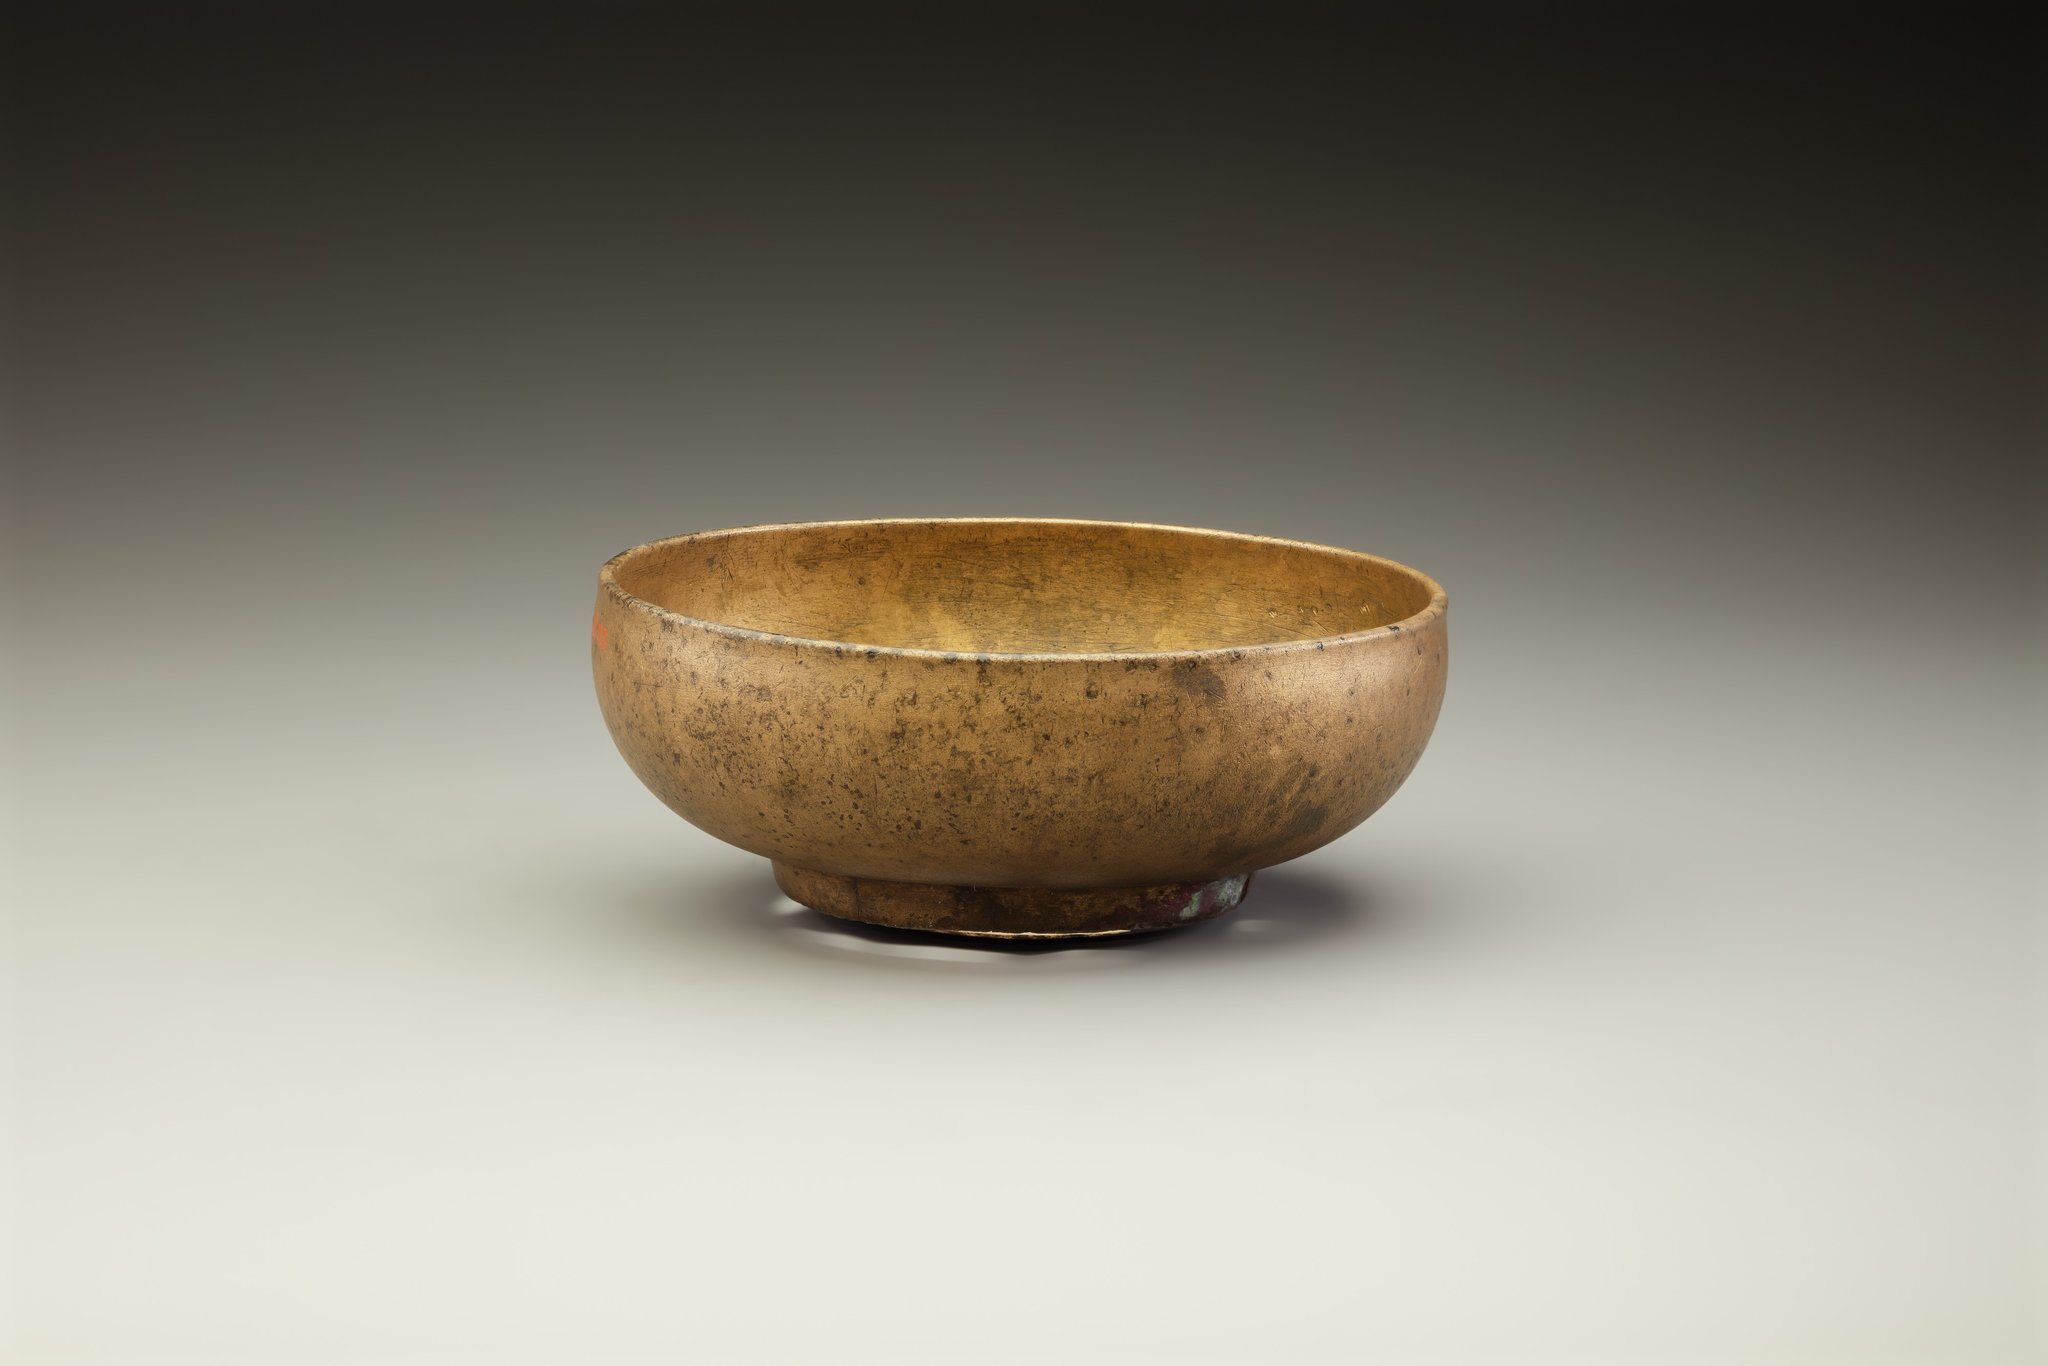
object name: bowl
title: One of five bowls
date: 1295-1070 BCE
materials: bronze, copper alloy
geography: egypt